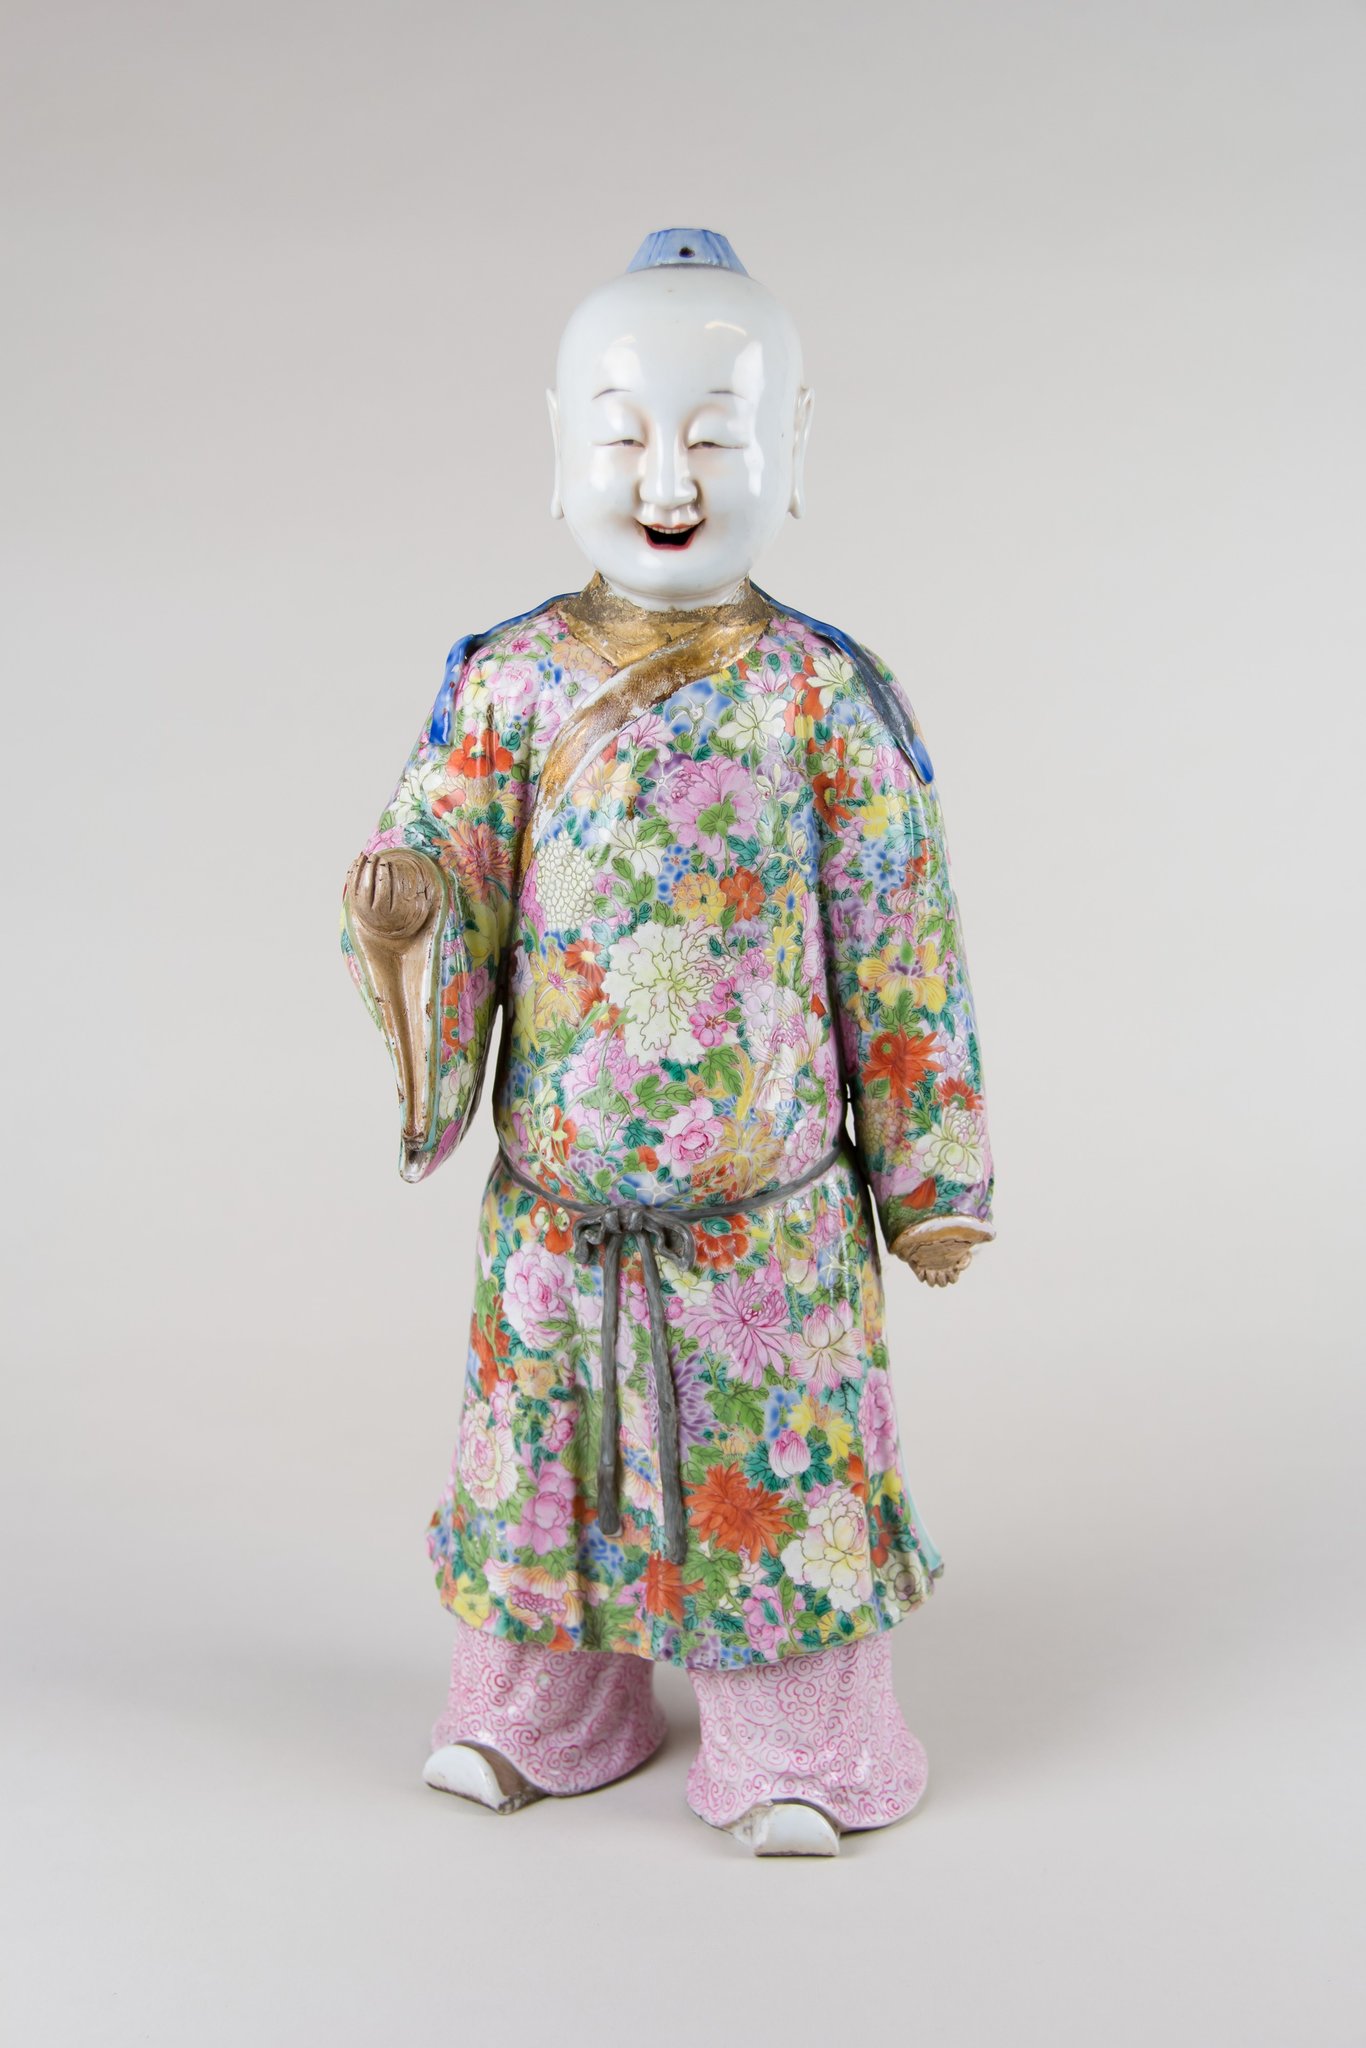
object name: figure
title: Figure of an immortal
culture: chinese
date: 1751-1800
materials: enamel, porcelain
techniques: overglaze, painting, polychrome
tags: boys